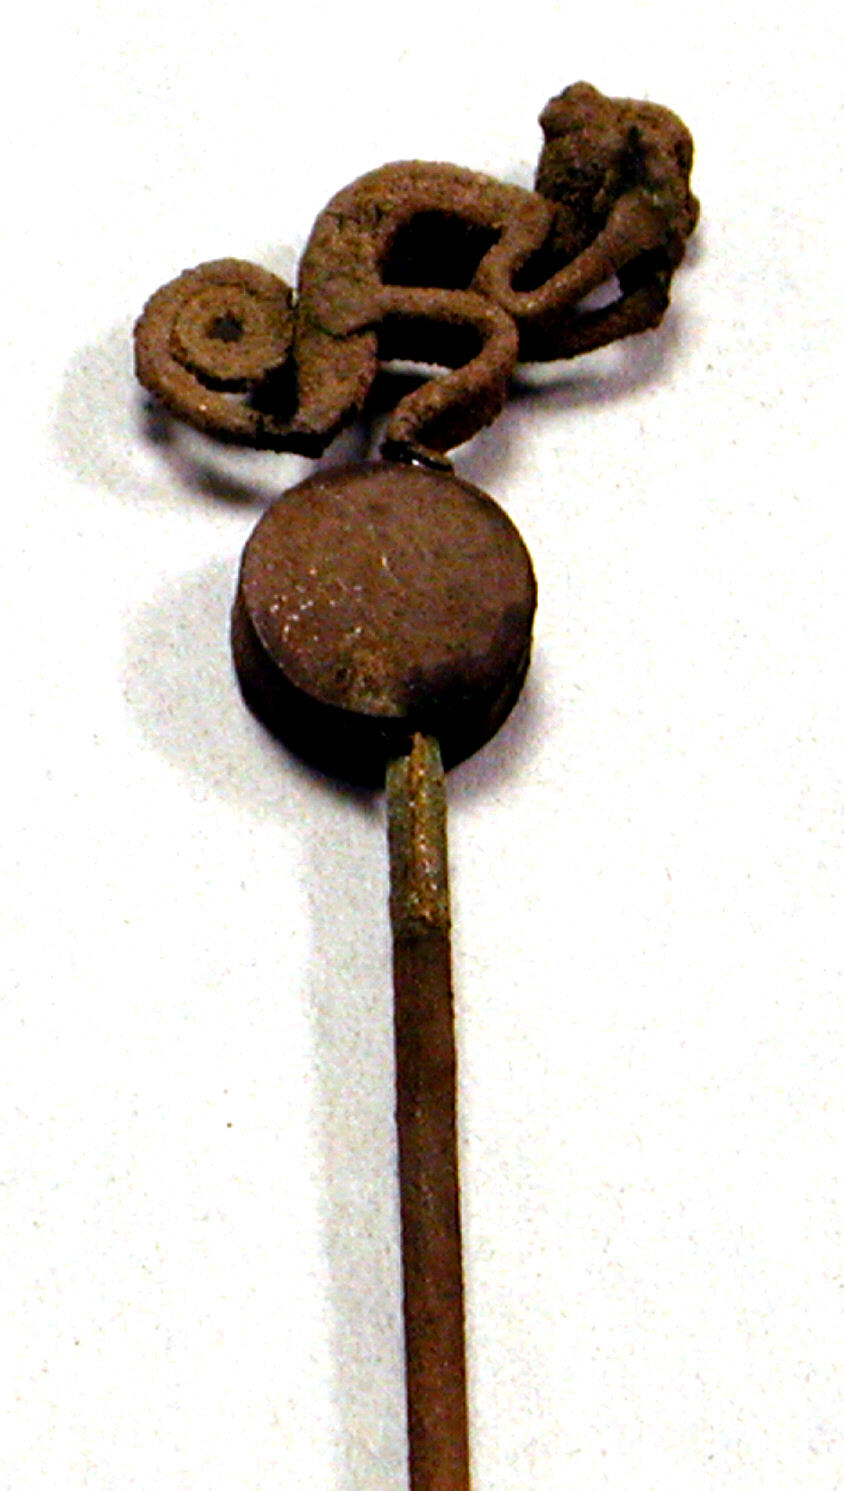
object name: pin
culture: chimú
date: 1201-1500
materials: silver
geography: peru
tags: animals